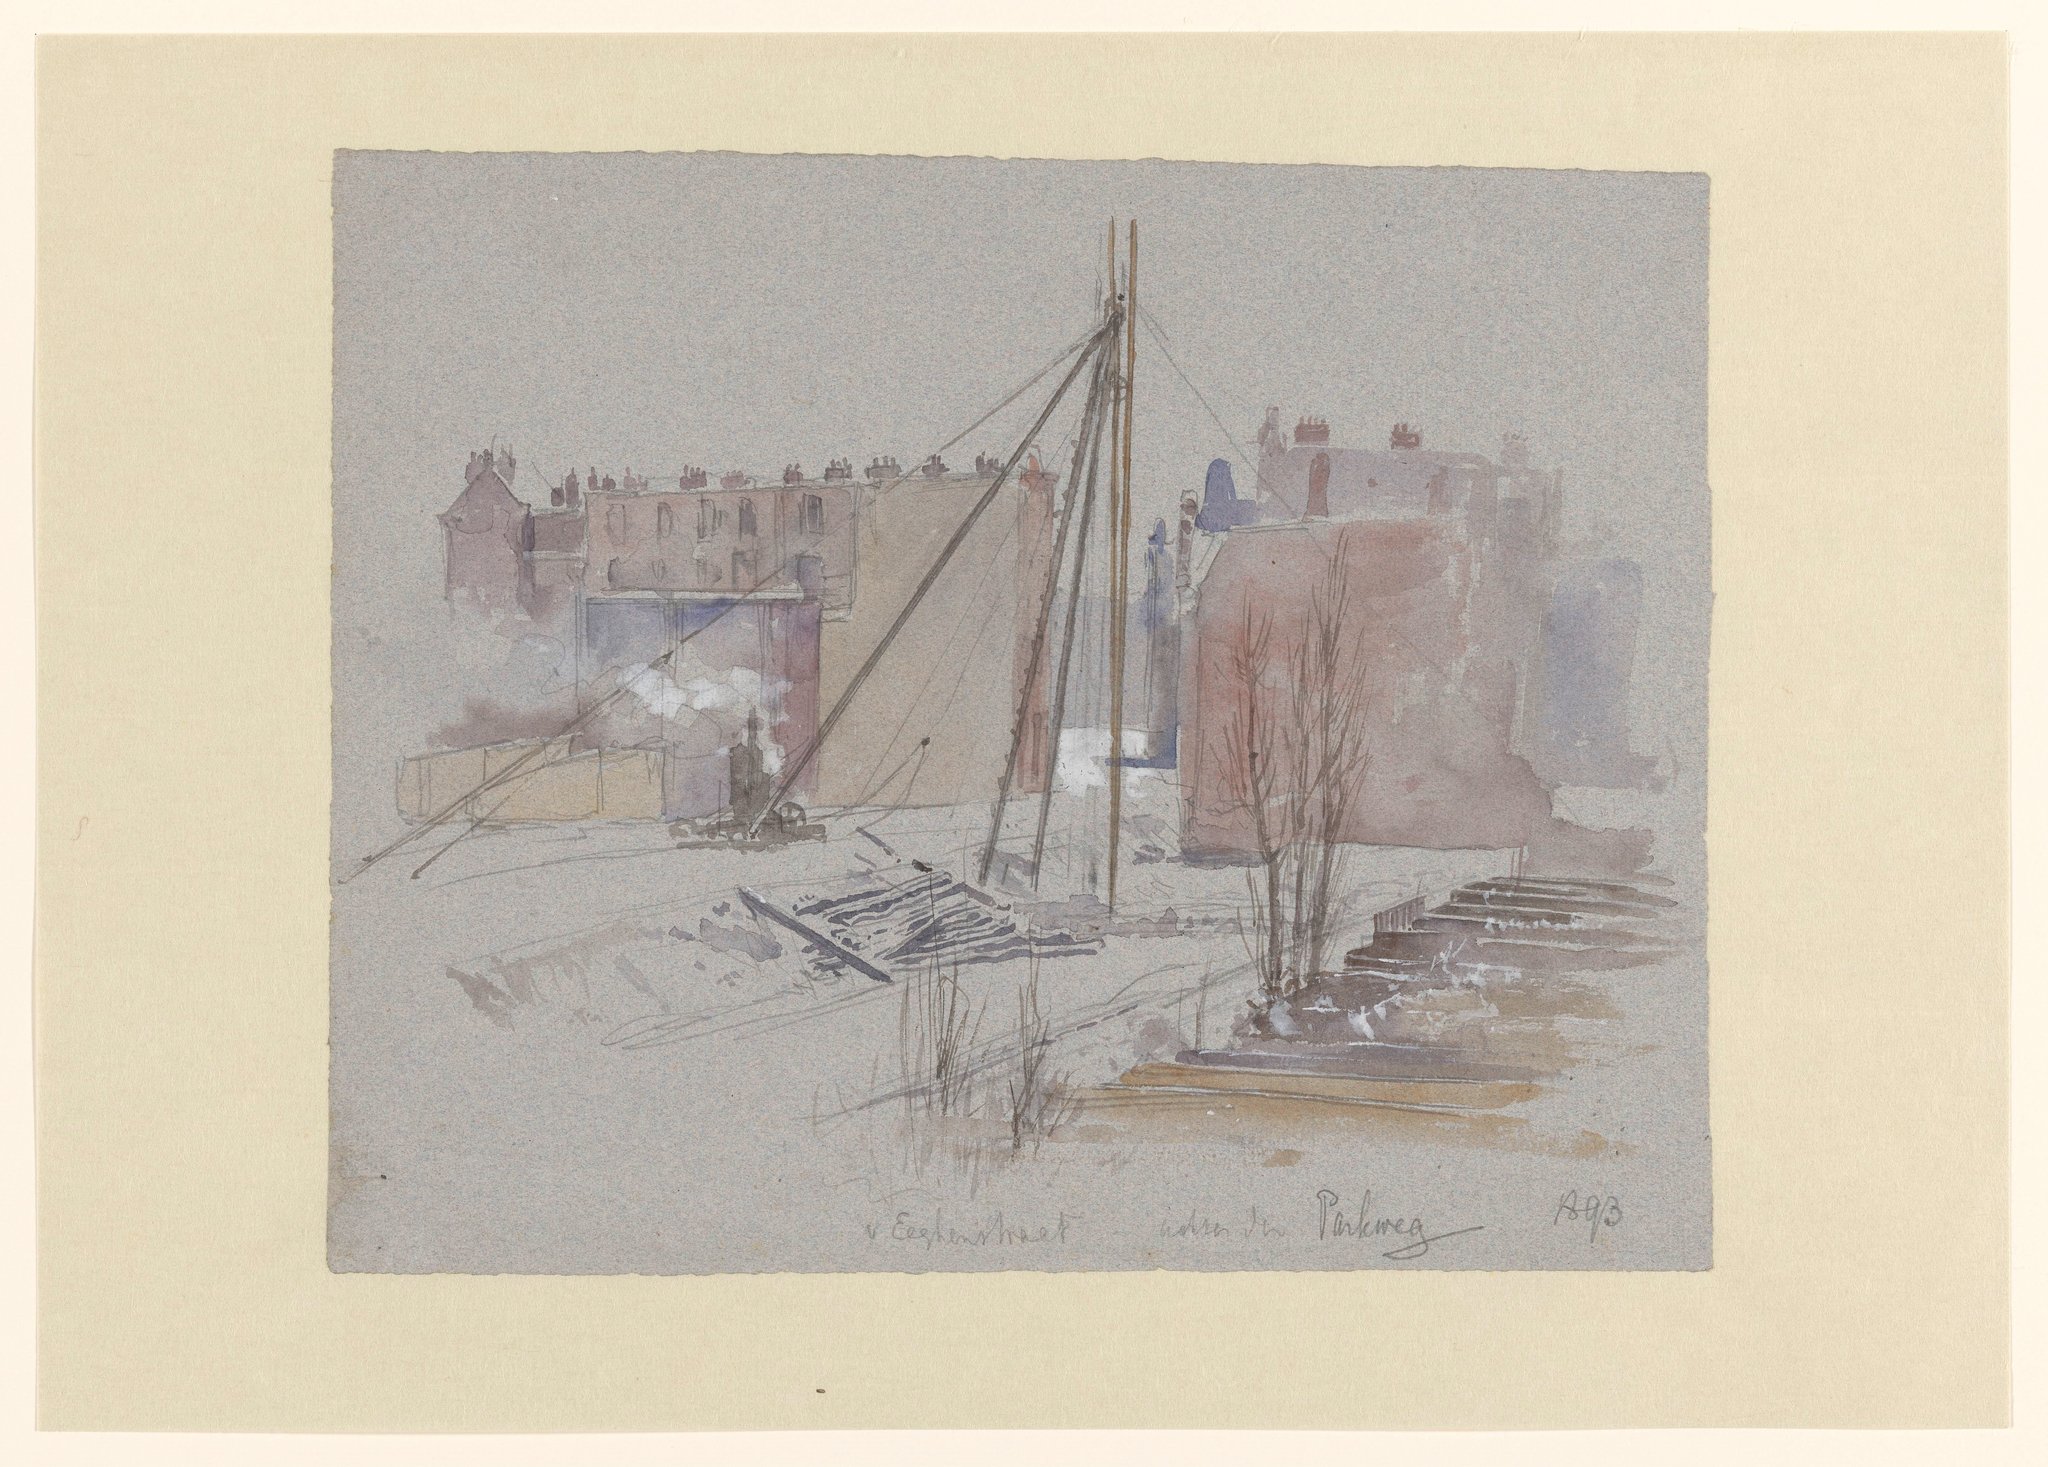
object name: watercolor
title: Heiwerkzaamheden aan de Van Eeghenstraat, achter de Parkweg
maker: jan hoynck van papendrecht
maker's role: draughtsman, painter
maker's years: 1858-1933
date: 1893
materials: paper, pencil, watercolor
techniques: brush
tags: ramming, driving piles (~ building activities), amsterdam